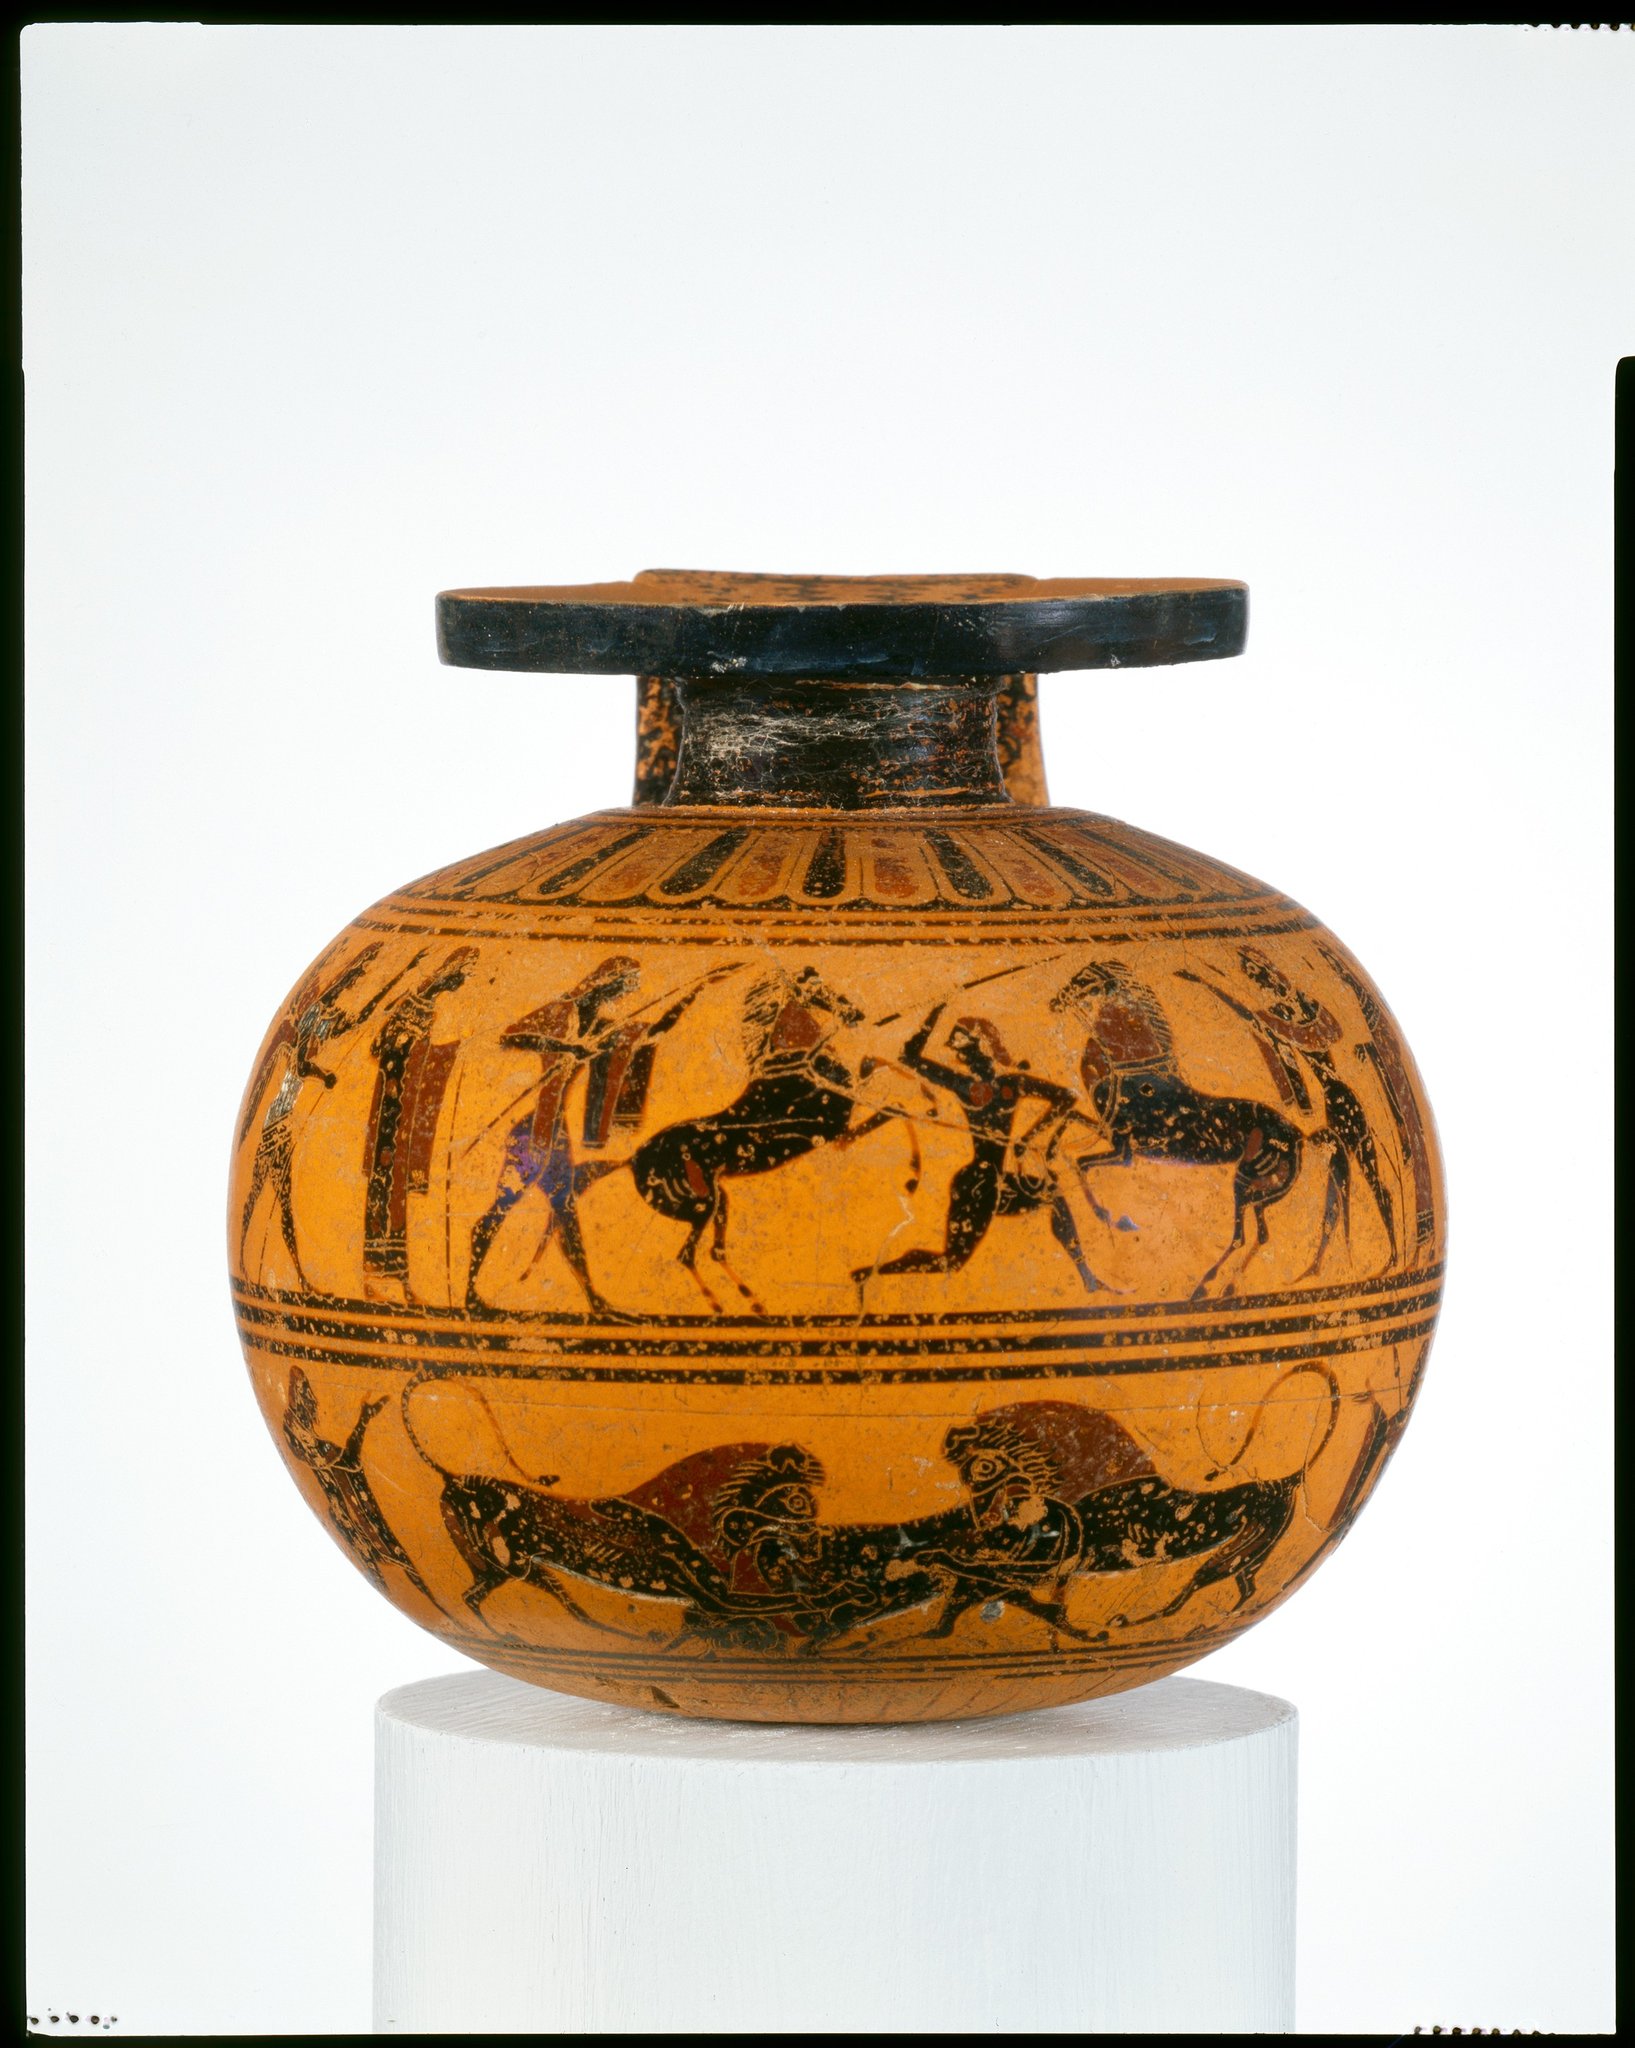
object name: aryballos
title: Terracotta aryballos (oil flask)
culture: greek, attic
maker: amasis painter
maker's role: artist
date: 550 BCE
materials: terracotta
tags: dionysus,horses